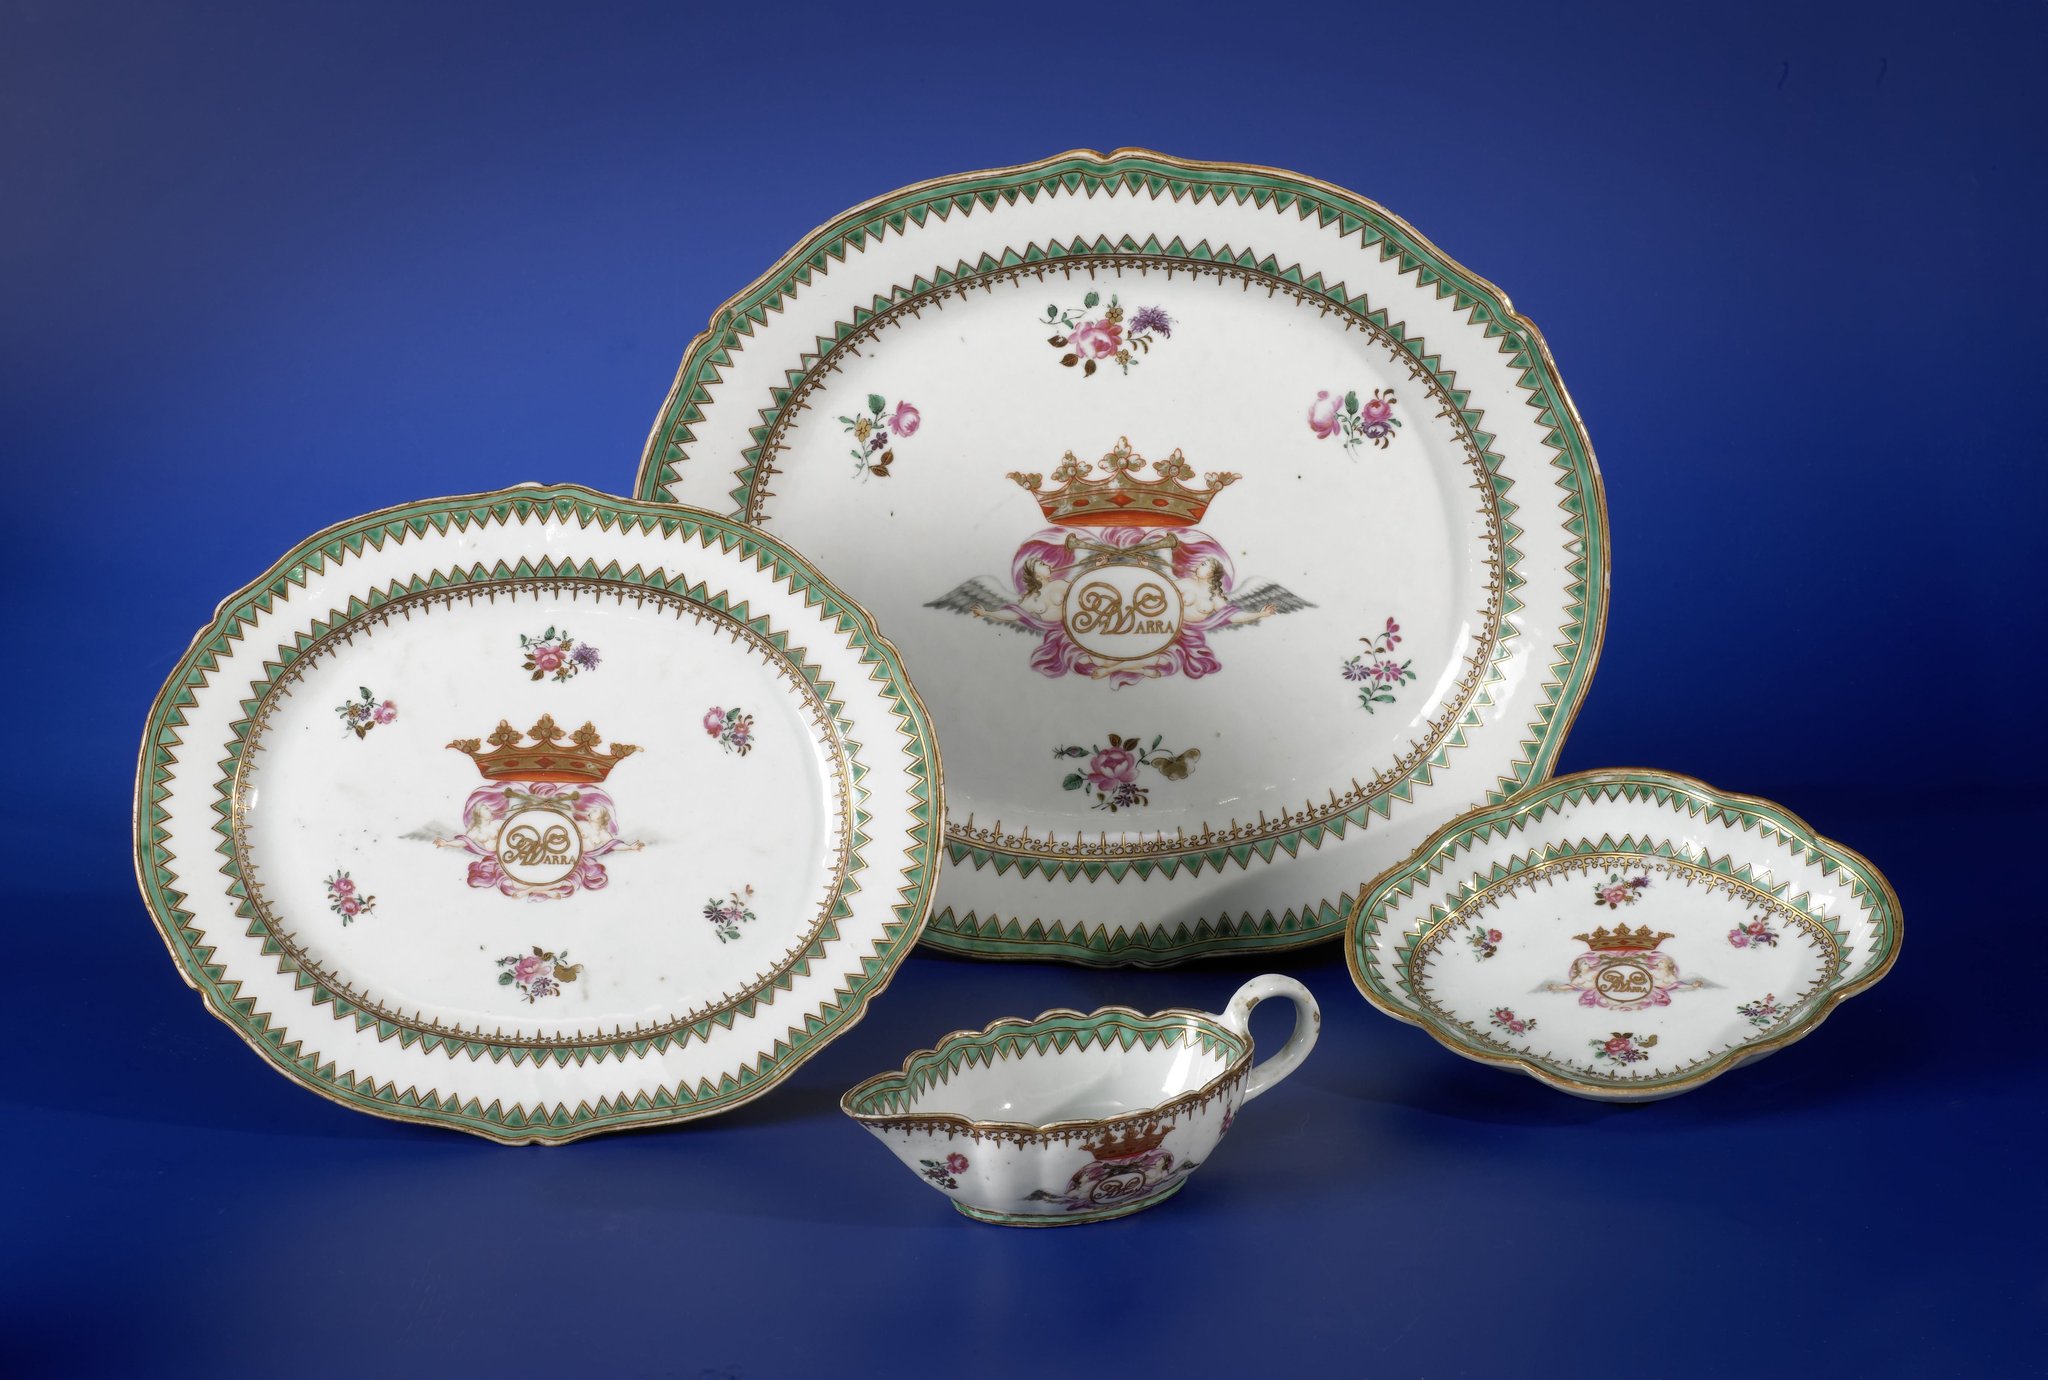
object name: platter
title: Oval dish with the arms of the Van der Parra family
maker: Anonymous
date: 1750-1774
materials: glaze, gold, paint, porcelain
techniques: firing, gilding, turning, vitrification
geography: china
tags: dutch east indies, the, sri lanka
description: Ovale schotel van porselein met geschulpte rand, beschilderd op het glazuur in rood, roze, groen, paars, zwart en goud. In het centrum het wapen van Petrus Albertus van de Parra (1714-1775). In het schild staat de naam ‘PA VD PARRA’ in goud en ijzerrood. Boven het wapen is een kroon afgebeeld en het dekkleed bestaat uit een draperie in paars en aan weerszijden van het wapen een engel die de bazuin blaast. Hieromheen zijn bloemtakken afgebeeld. Op de wand een band van spearheads in goud. De rand wordt begrensd met een dubbel zaagtand-motief. Wapenporselein.